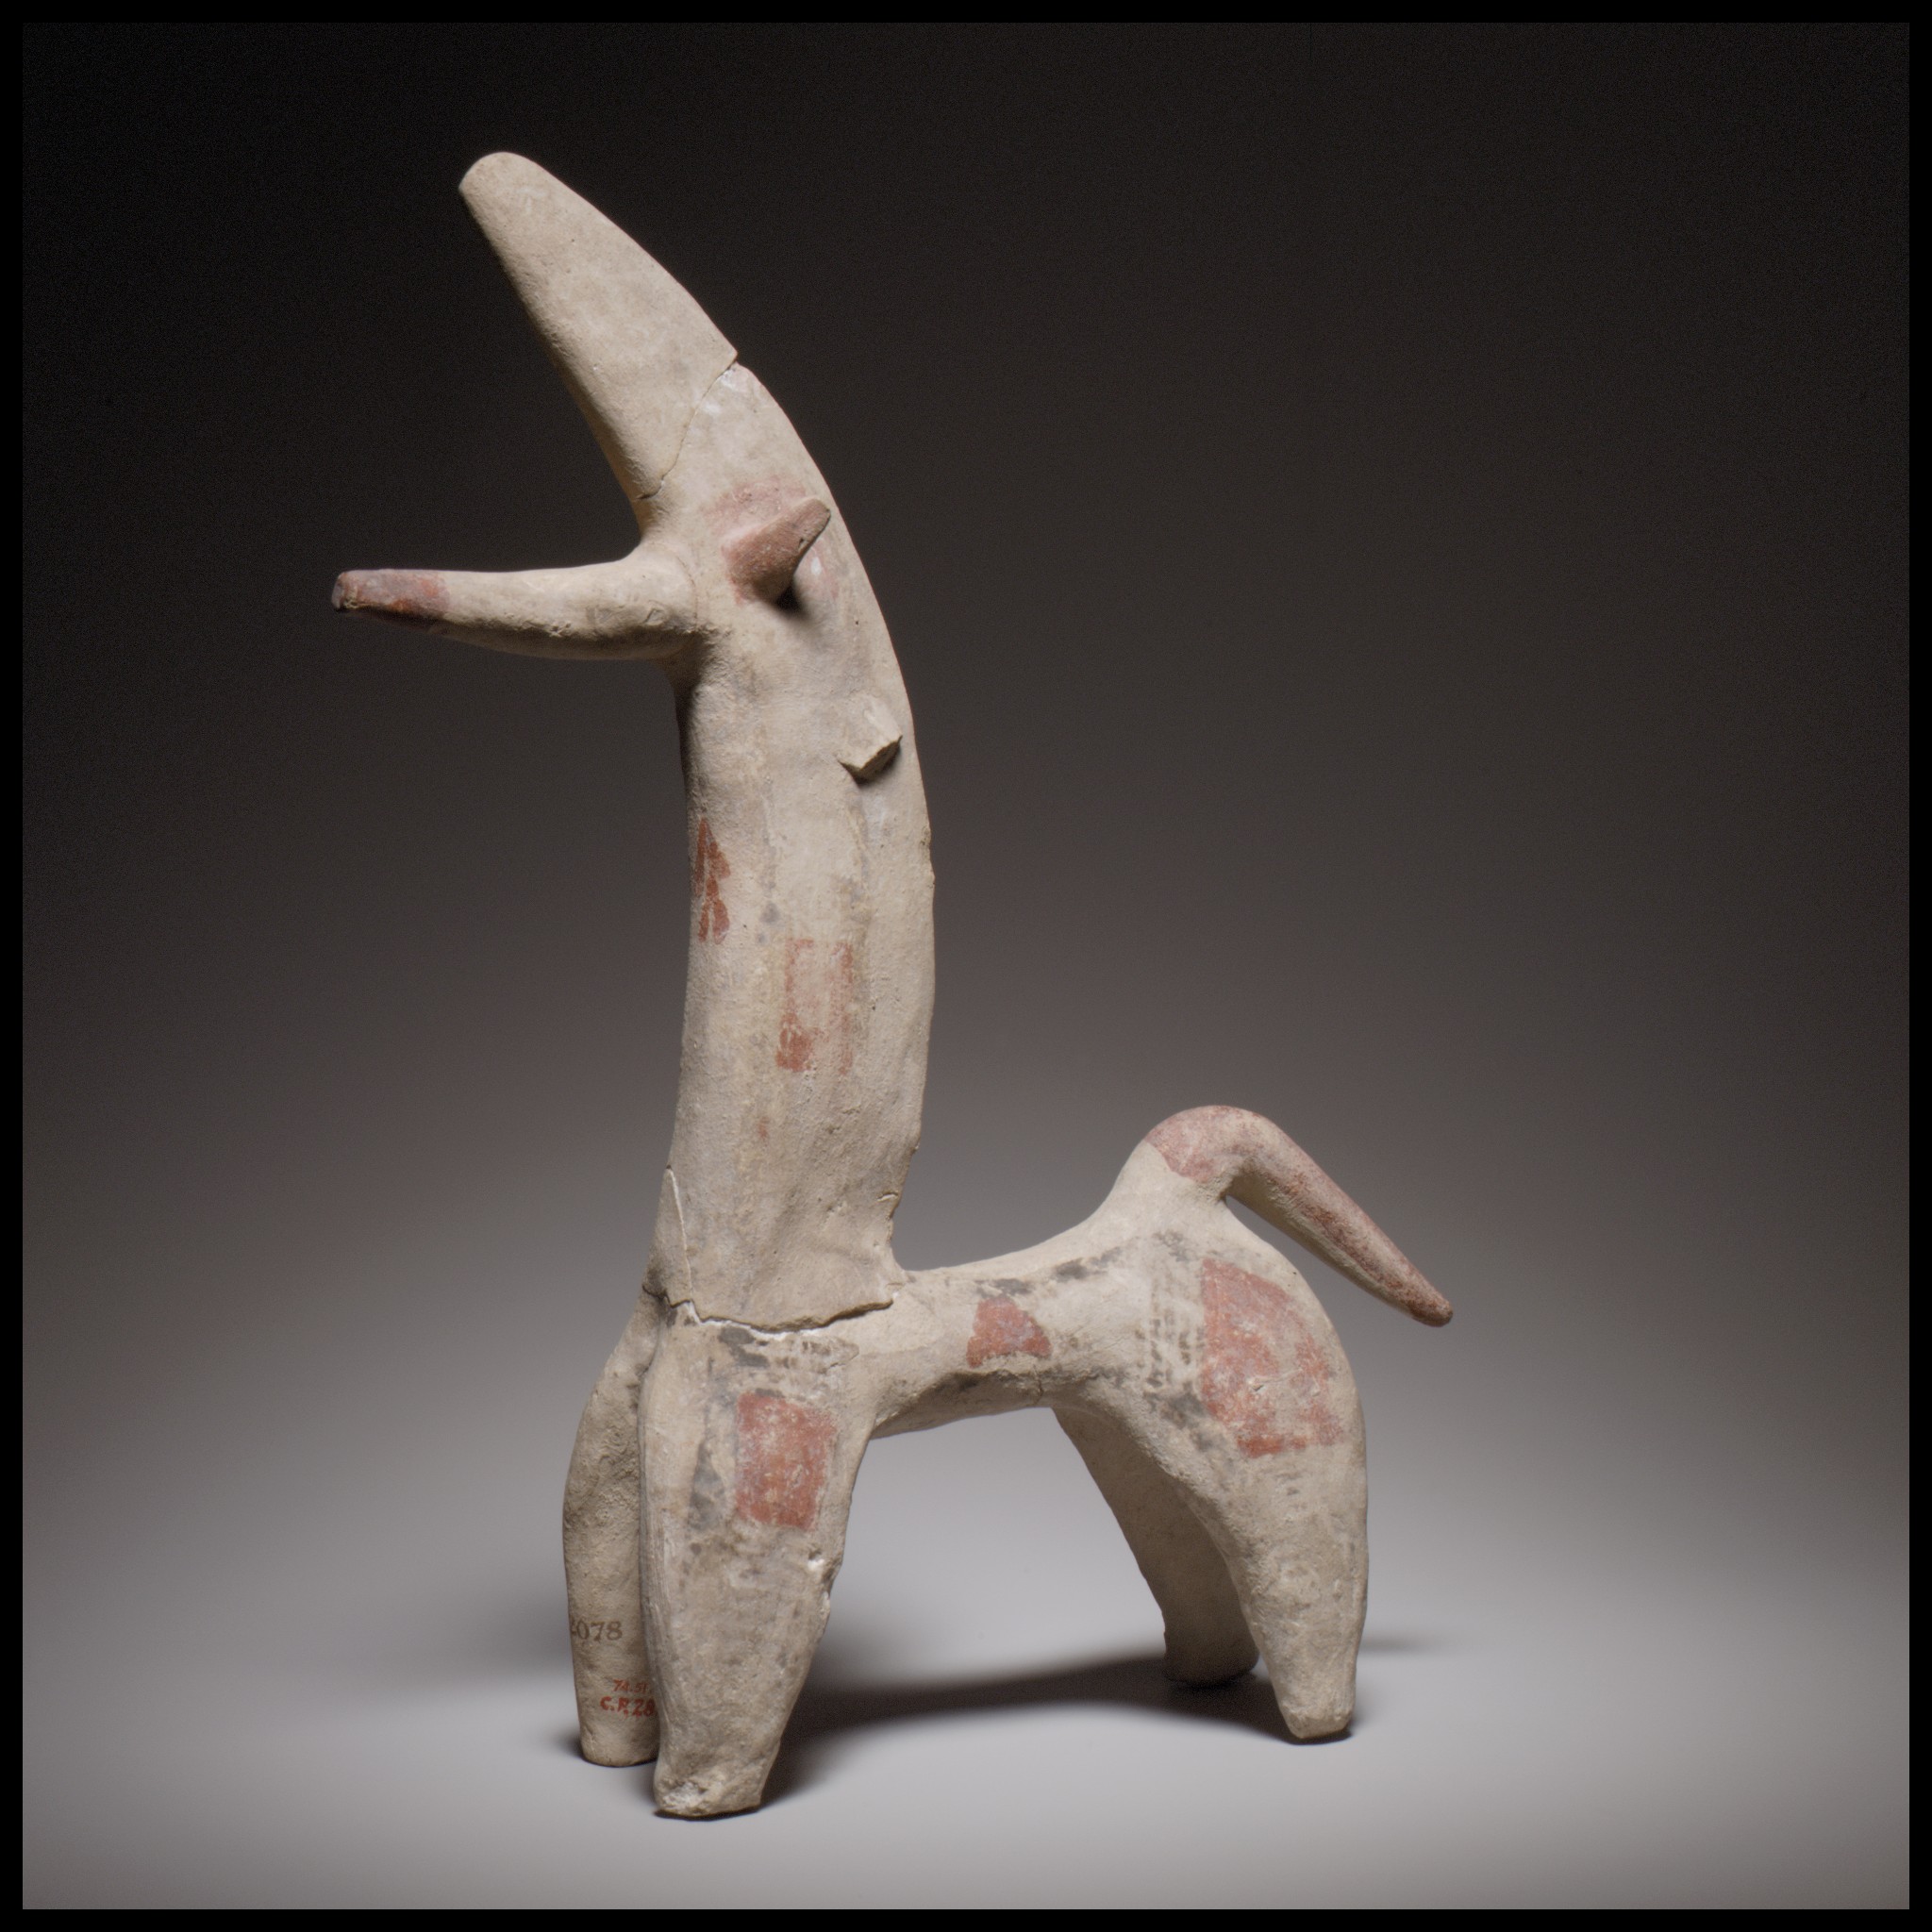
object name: statuette of a horse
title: Horse figurine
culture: cypriot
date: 750-600 BCE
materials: terracotta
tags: horses